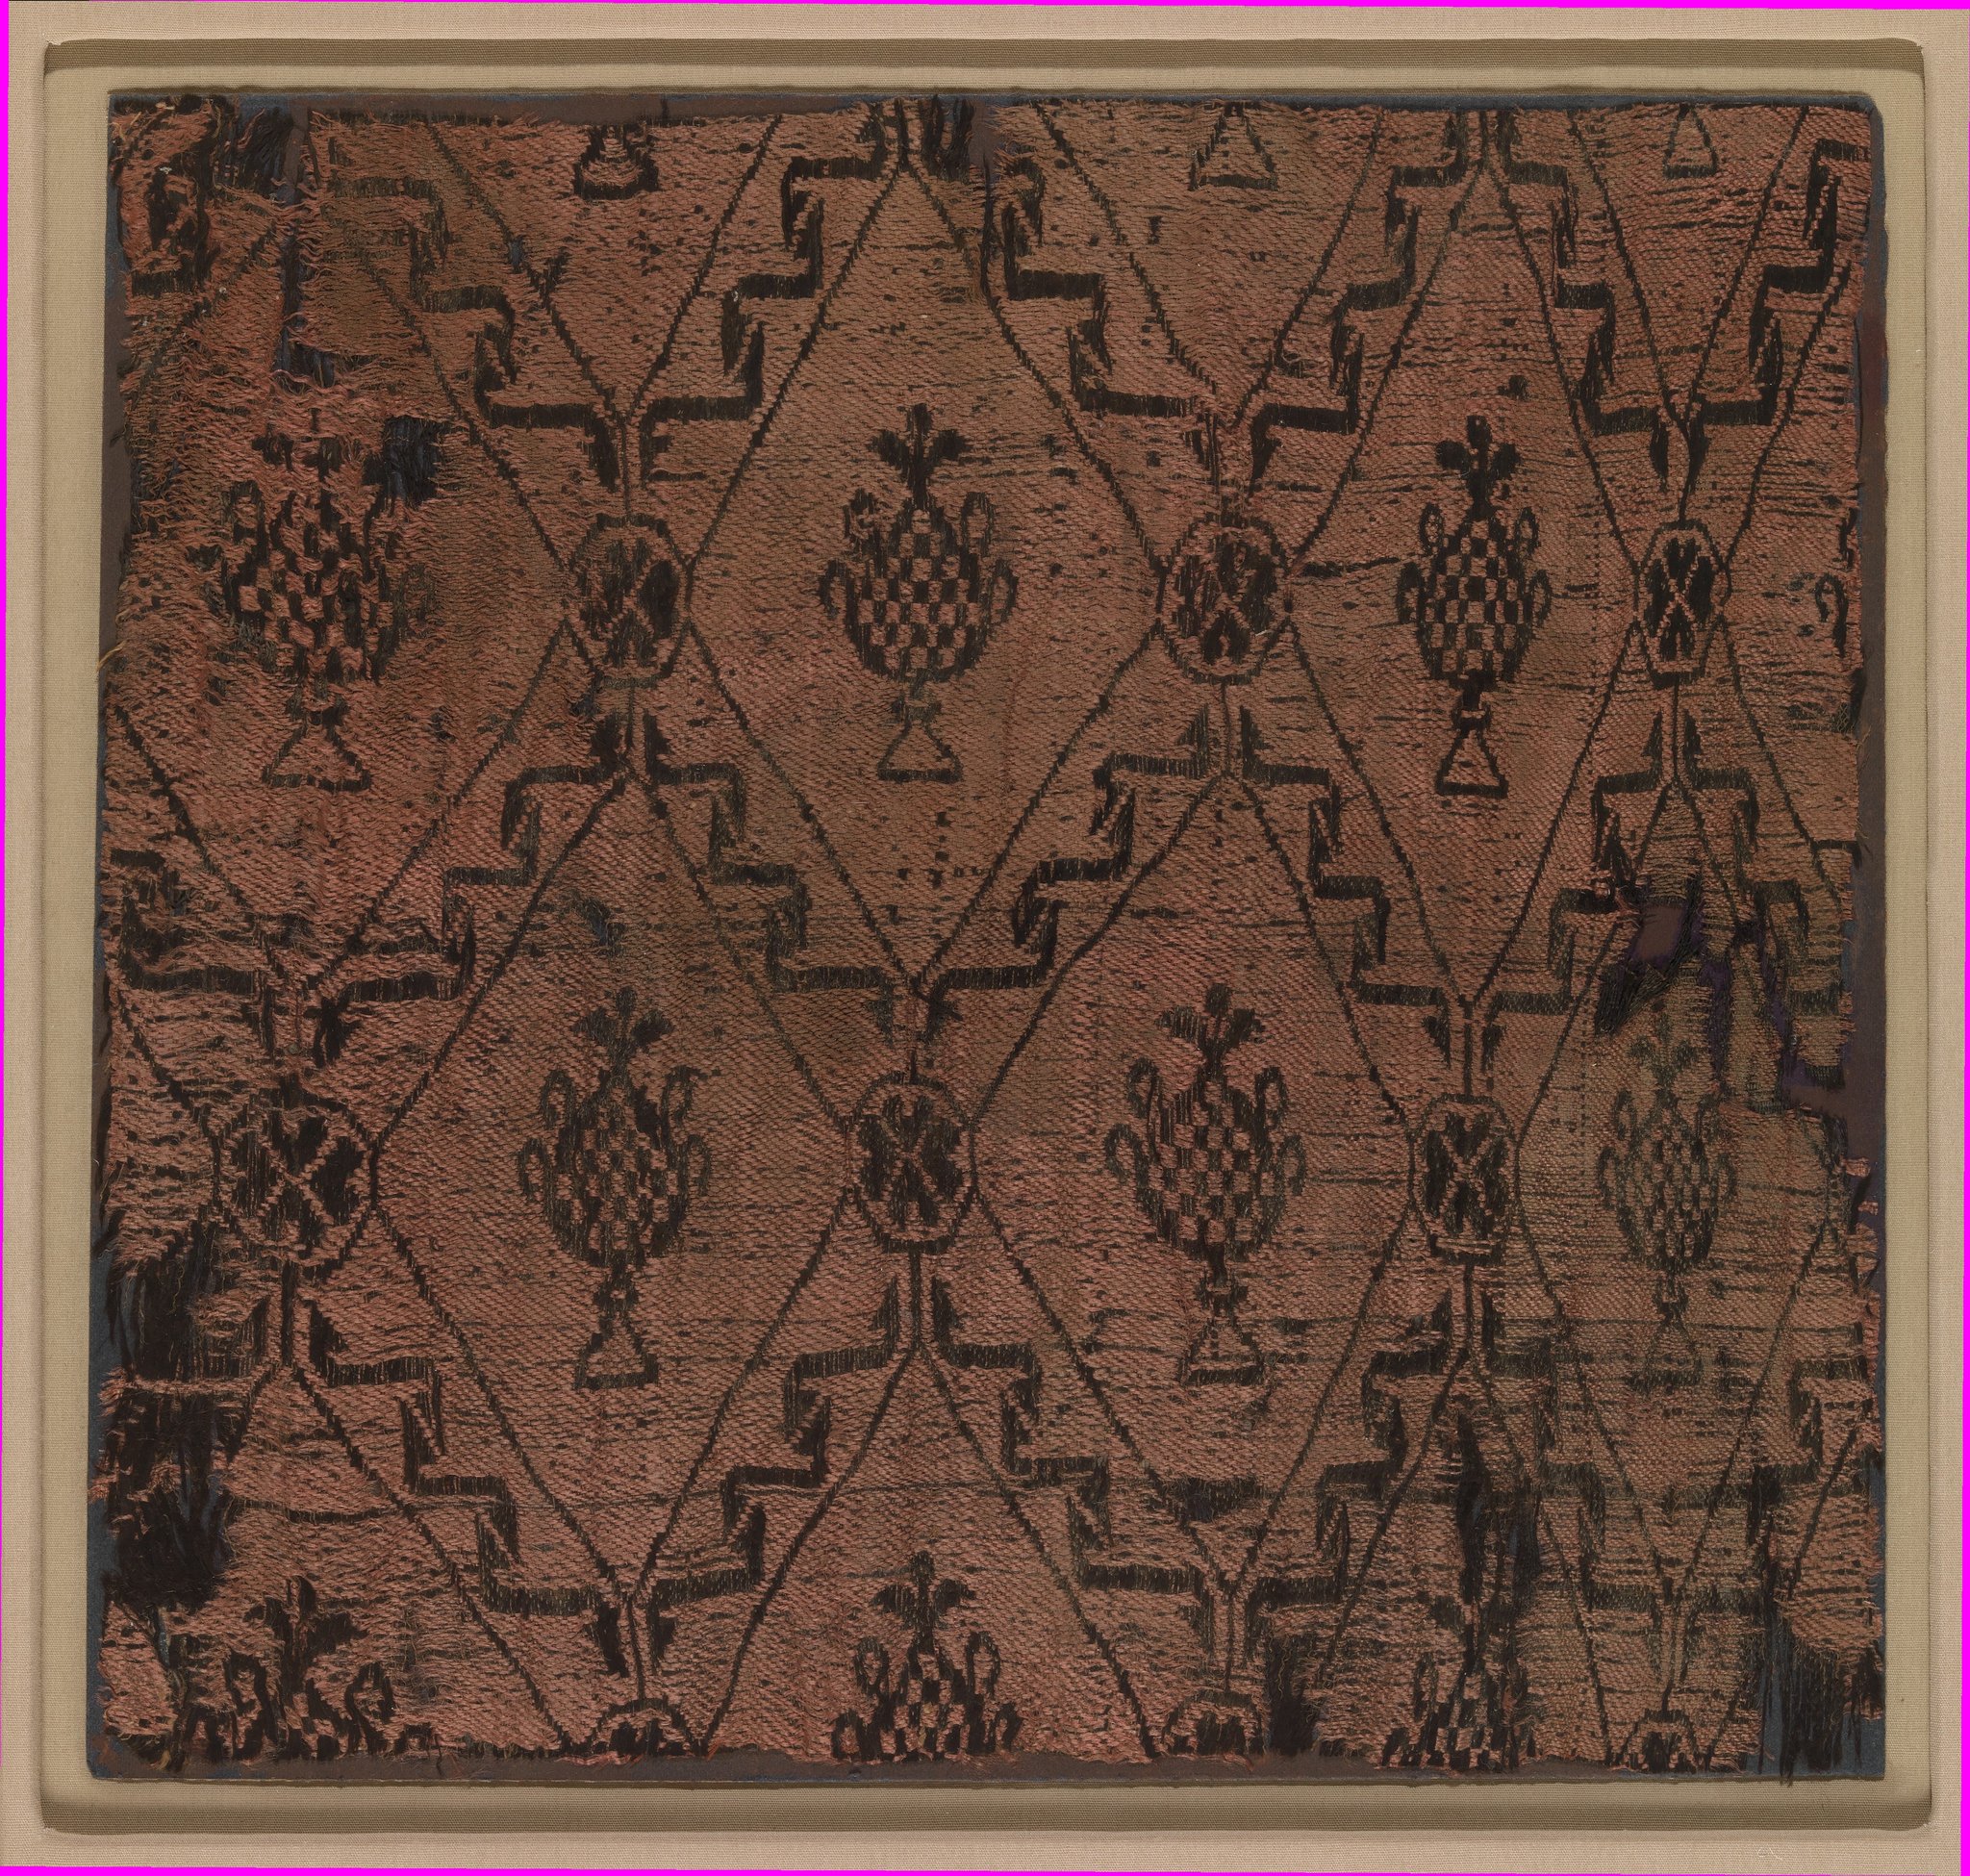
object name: fragment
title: Ribbon Lattice with Pinecone (?)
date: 701-900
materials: silk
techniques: weave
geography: egypt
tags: pinecones